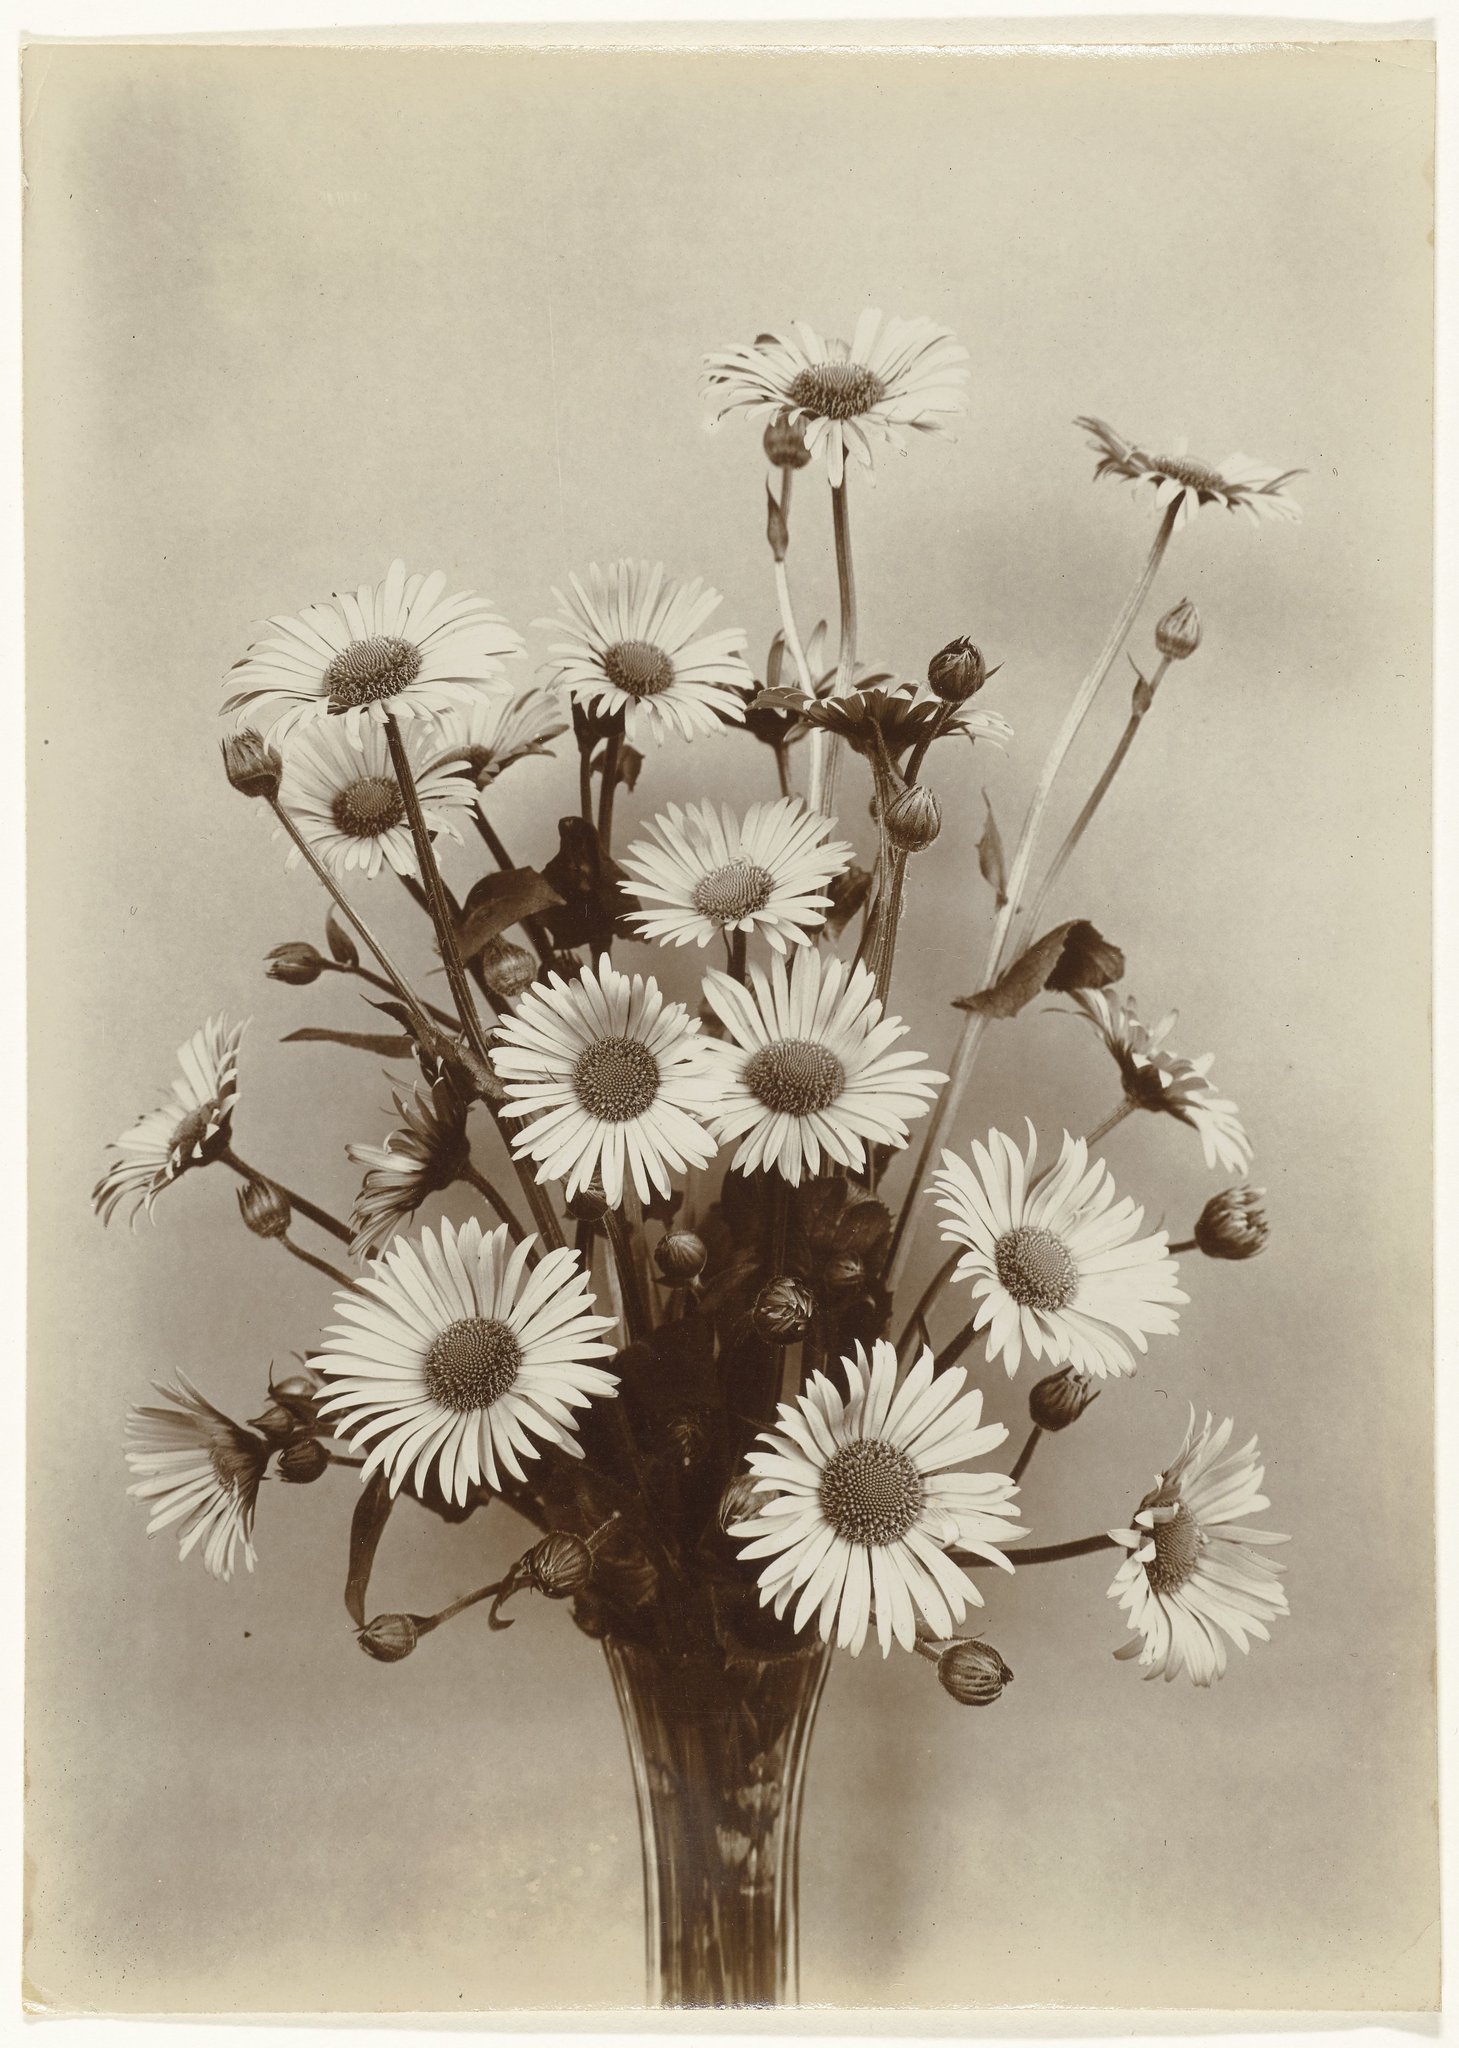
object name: photograph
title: Bosje weegbreezonnebloemen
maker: richard tepe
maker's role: fotograaf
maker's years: 1864-1952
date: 1900-1930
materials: photographic support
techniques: gelatin silver print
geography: netherlands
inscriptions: annotation: ‘Doronicum plantagineum / excelsum moerheim’, signature: ‘foto / R. Tepe’